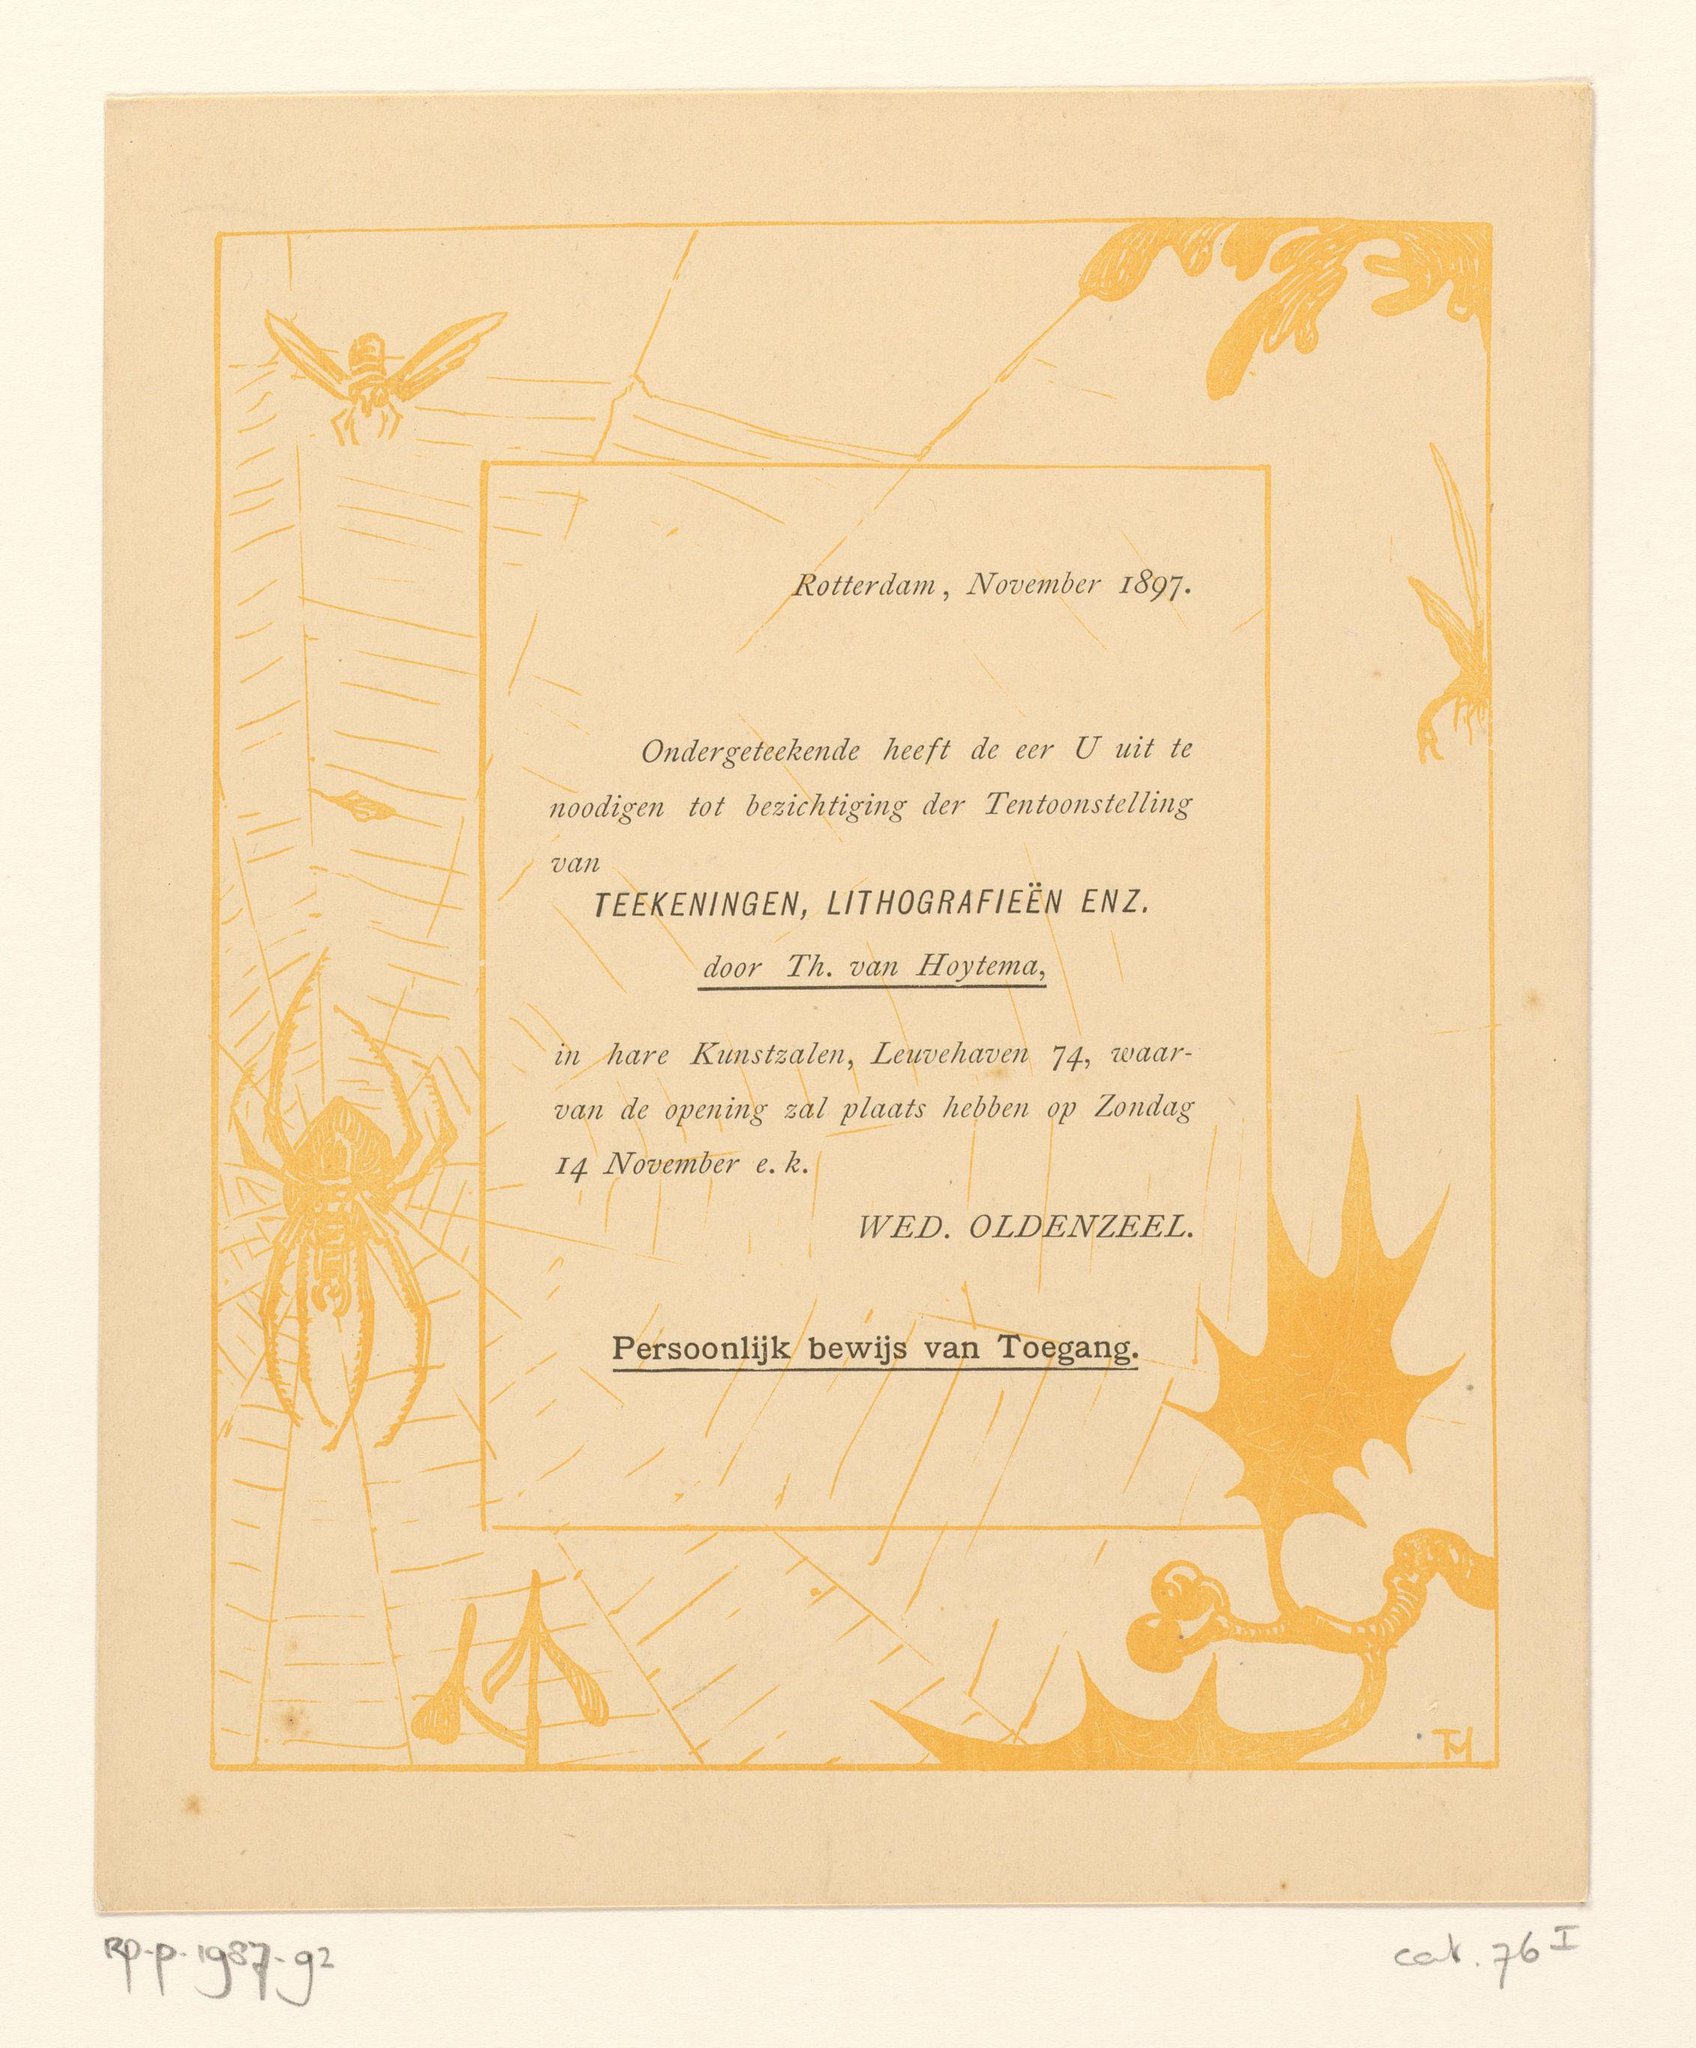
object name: invitation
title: Uitnodiging voor de tentoonstelling van werk van Theo van Hoytema bij Oldenzeel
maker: theo van hoytema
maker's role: draughtsman, painter, print maker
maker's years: 1863-1917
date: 1811-1897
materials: paper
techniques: letterpress printing, lithograph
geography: rotterdam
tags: the hague, painter, print maker, draughtsman, theo van hoytema, spiders, collection, exhibition, show, rotterdam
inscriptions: collector's mark: Lugt 2228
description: Een spin in haar web, met onder andere een gevangen insect. Met de tekst: 'Rotterdam, November 1897. Ondergeteekende heeft de eer U uit te noodigen tot bezichtiging der Tentoonstelling van teekeningen, lithografieën, enz. door Th. van Hoytema, in hare Kunstzalen, Leuvehaven 74, waarvan de opening plaats zal hebben op Zondag 14 November e.k. Wed. Oldenzeel.